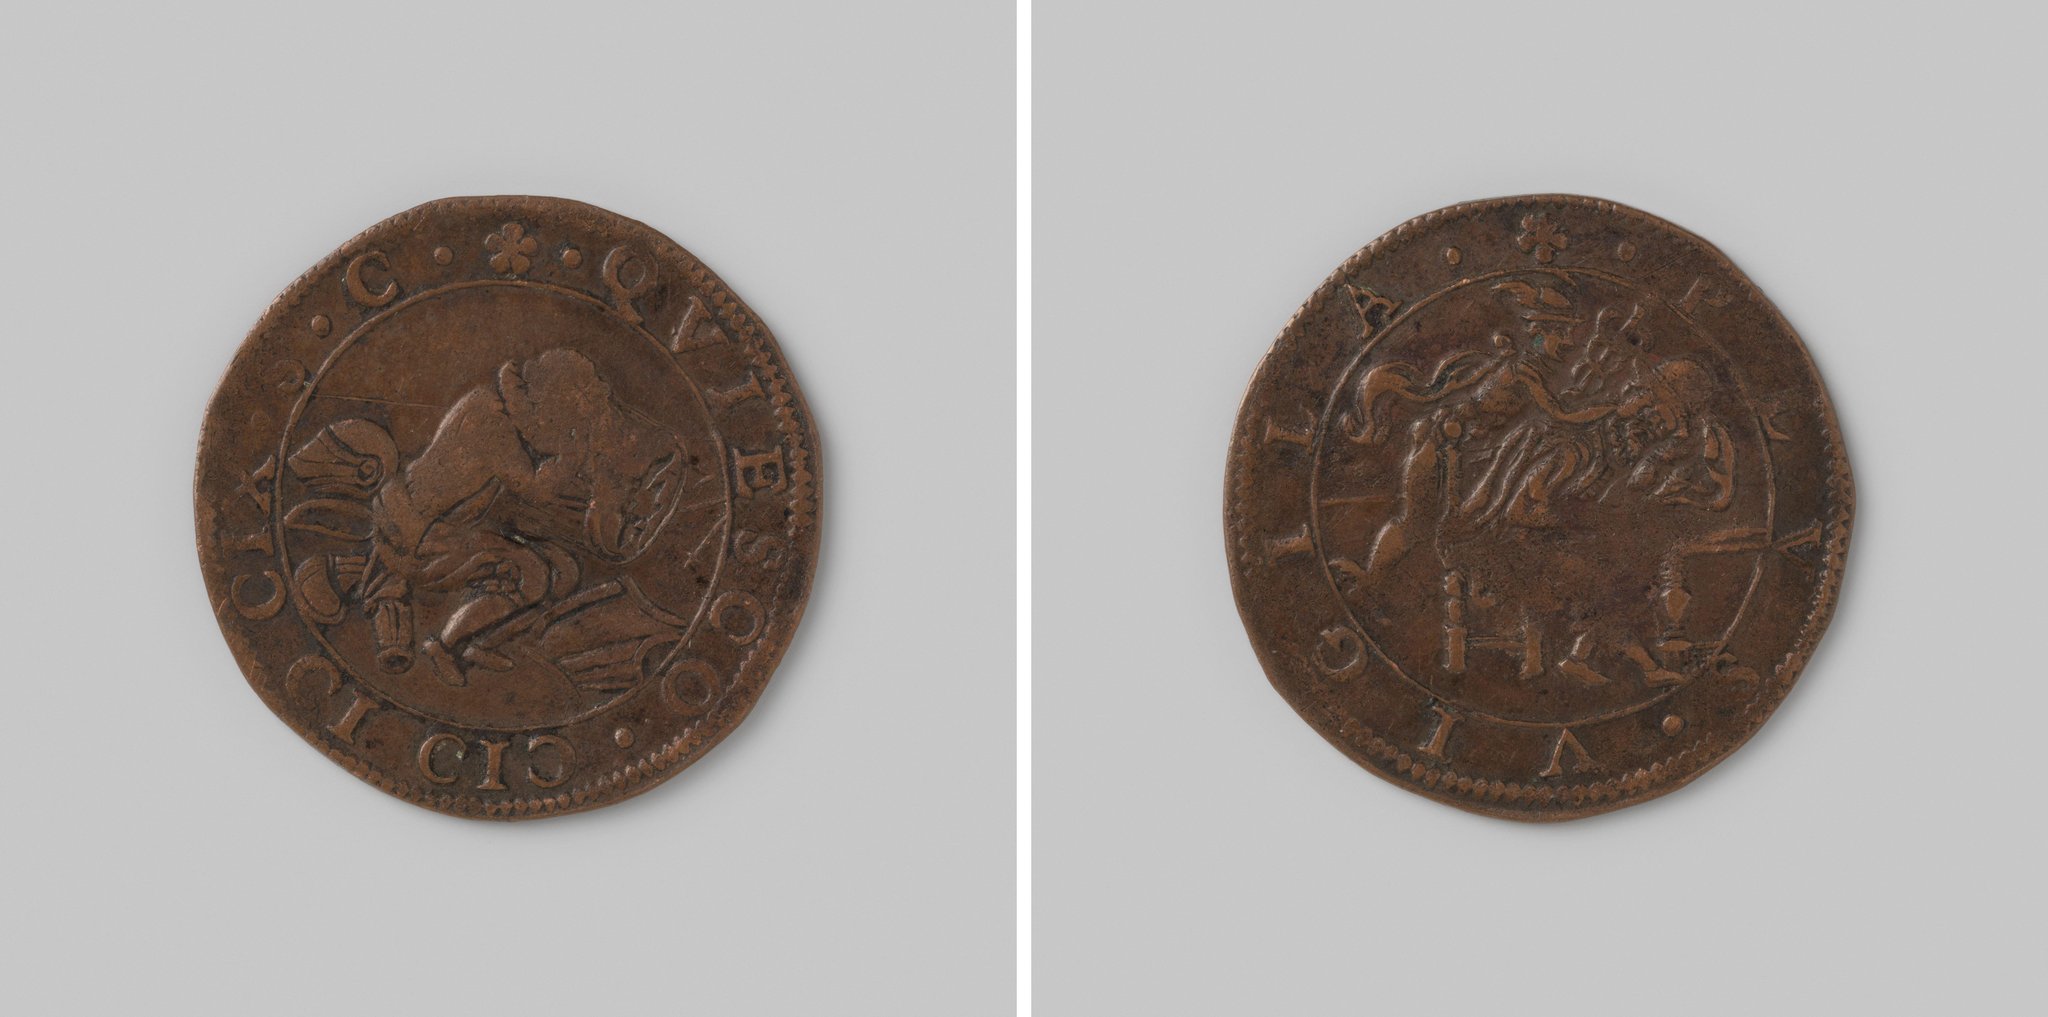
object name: history medal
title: Rekenpenning uit Dordrecht opwekkend tot waakzaamheid 1609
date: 1609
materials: copper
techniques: striking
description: Koperen penning, op de voorzijde een slapend soldaat naast zijn afgelegde harnas, met omschrift, op de keerzijde Mercurius die een slapend man aan het oor trekt, met omschrift.